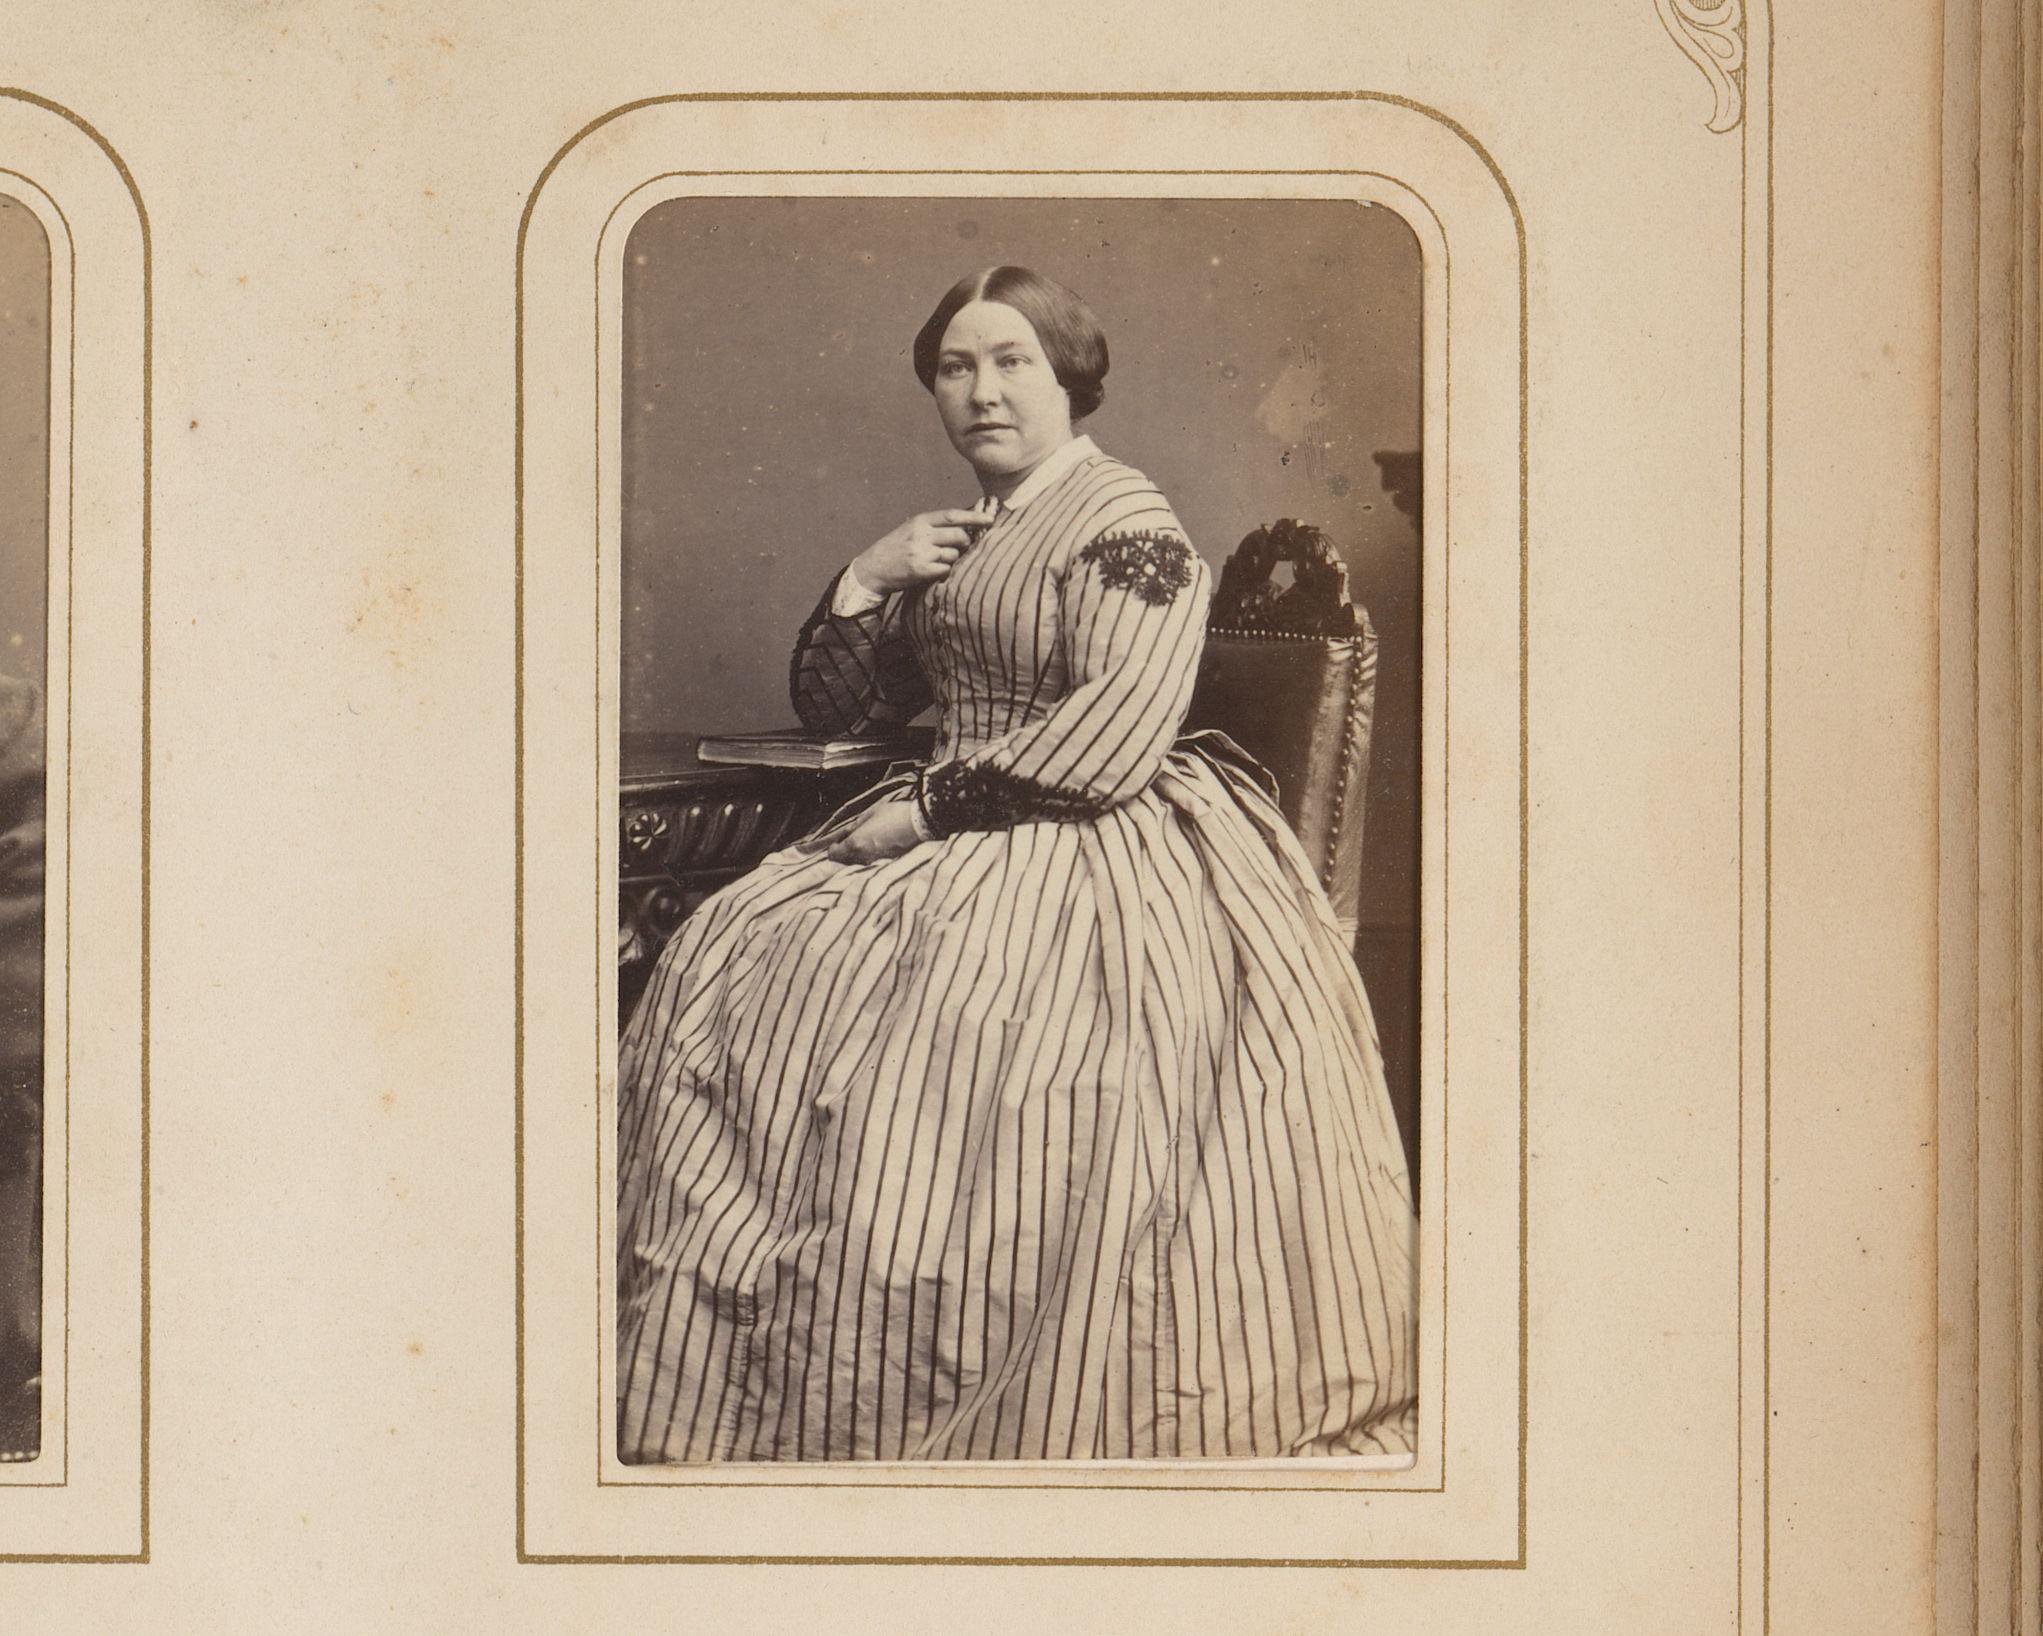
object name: carte de visite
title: Portret van een zittende vrouw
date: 1862-1900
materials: cardboard, photographic support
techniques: albumen print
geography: amsterdam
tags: sitting figure - aa - female human figure, historical persons - bb - woman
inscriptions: inscription: ‘PHOTOGr ATELIER/ WEGENER & MOTTU,/ KALVERSTRAAT/ Over den Heyligenweg D. 26/ AMSTERDAM’